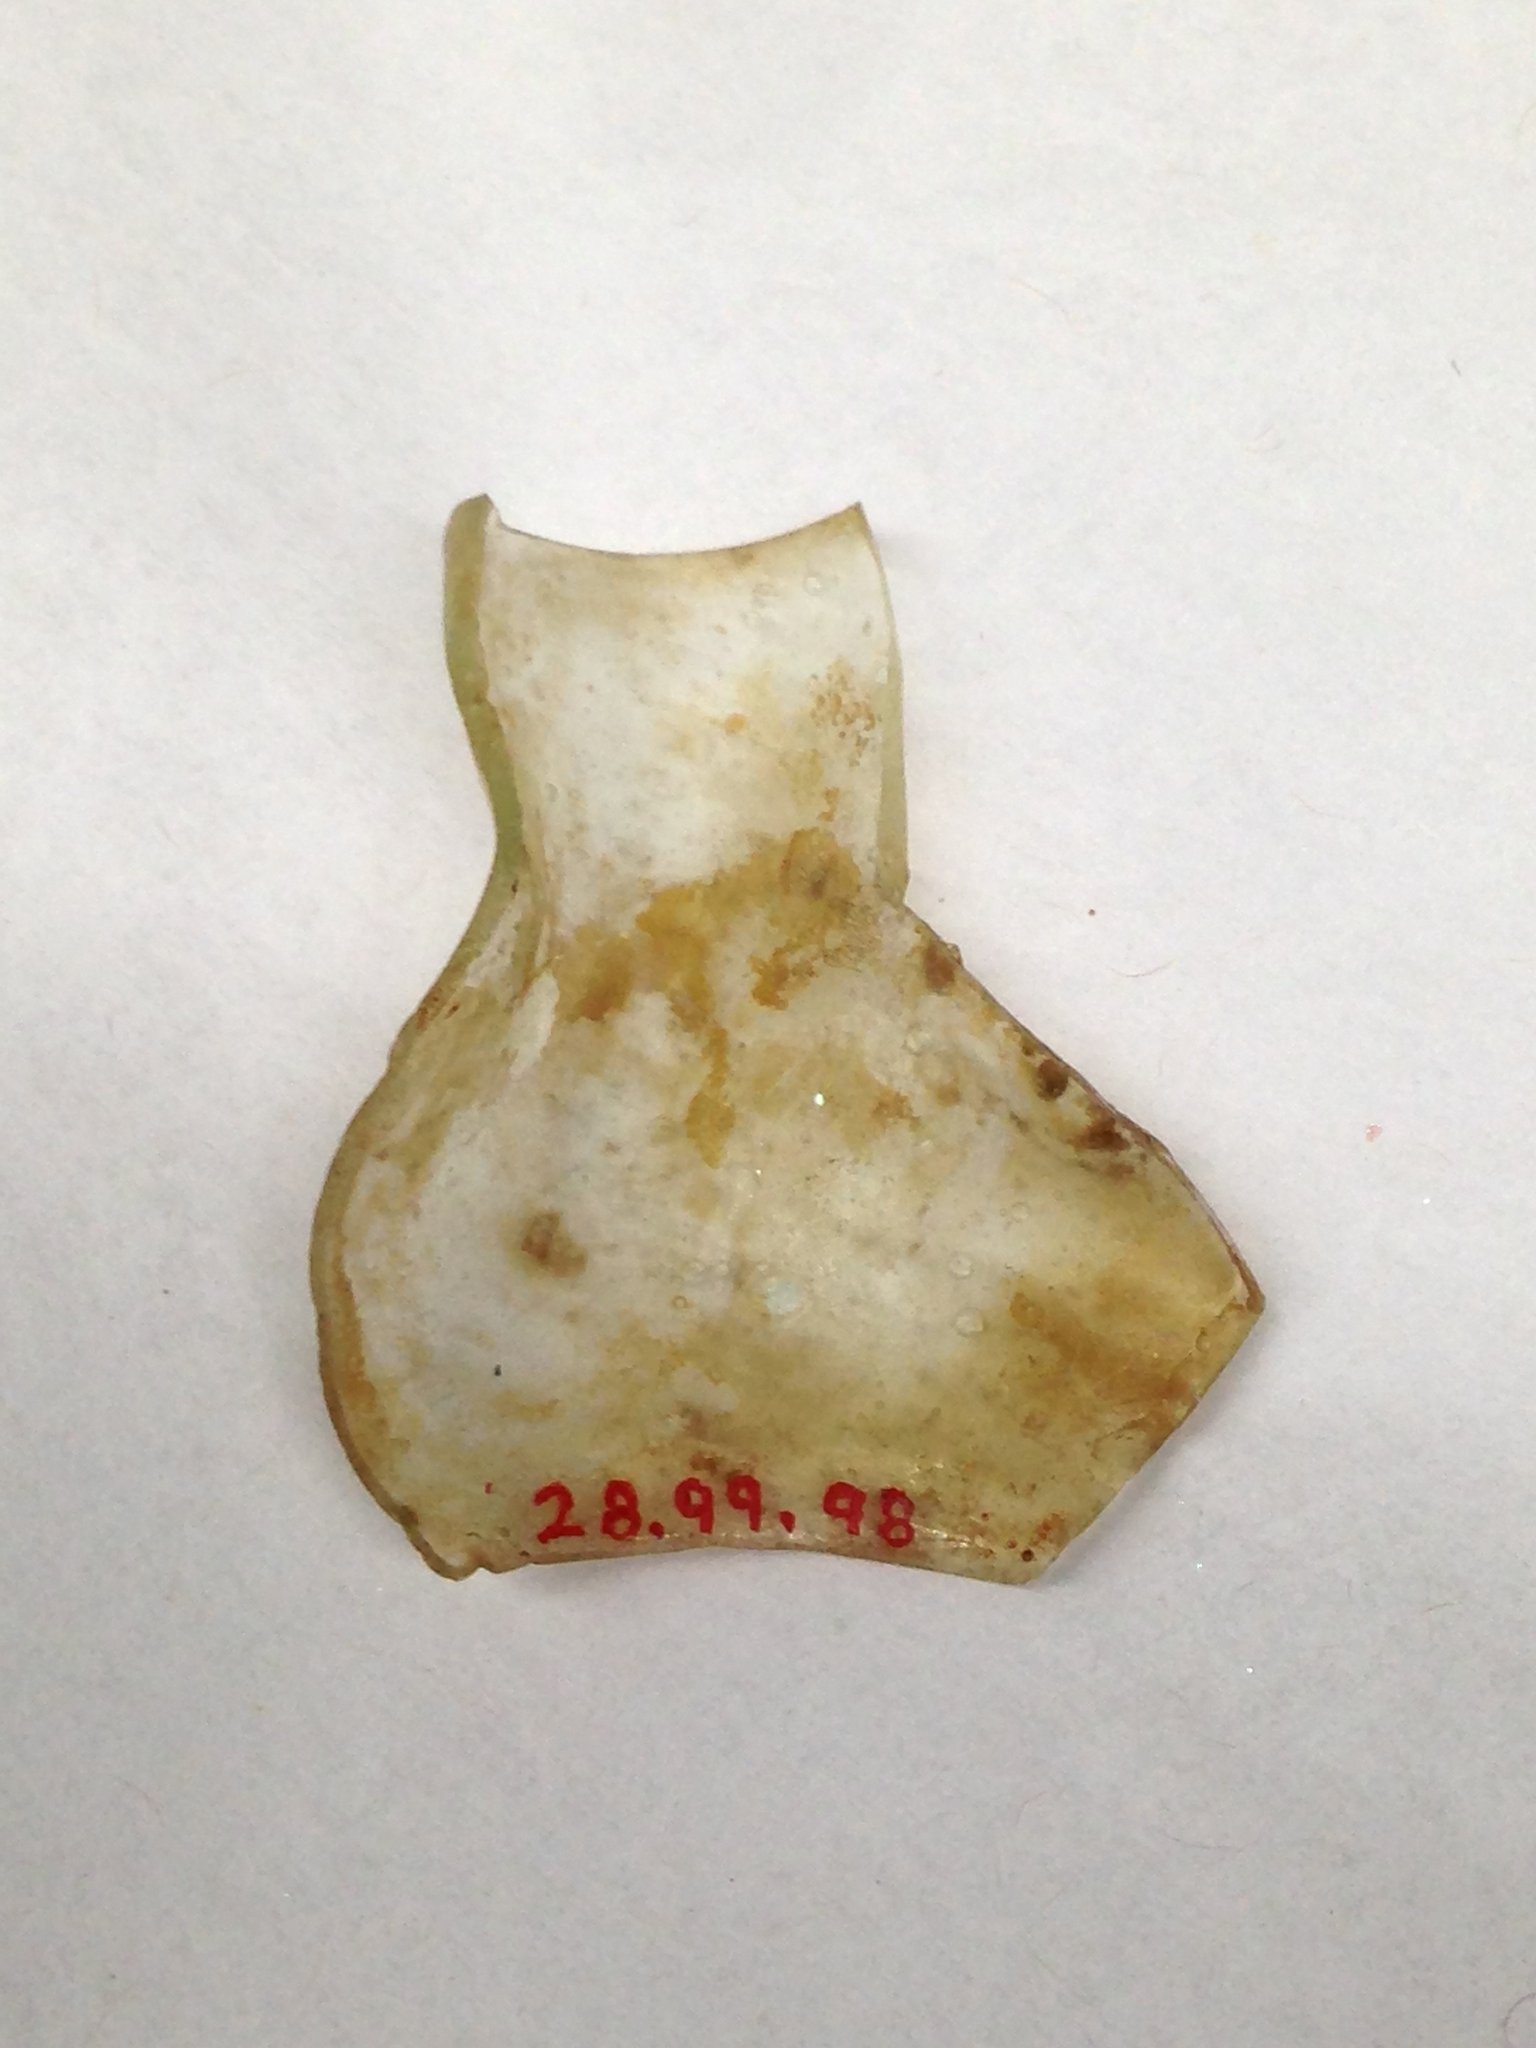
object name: fragment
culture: european or middle eastern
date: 1150-1250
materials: ceramic, glass